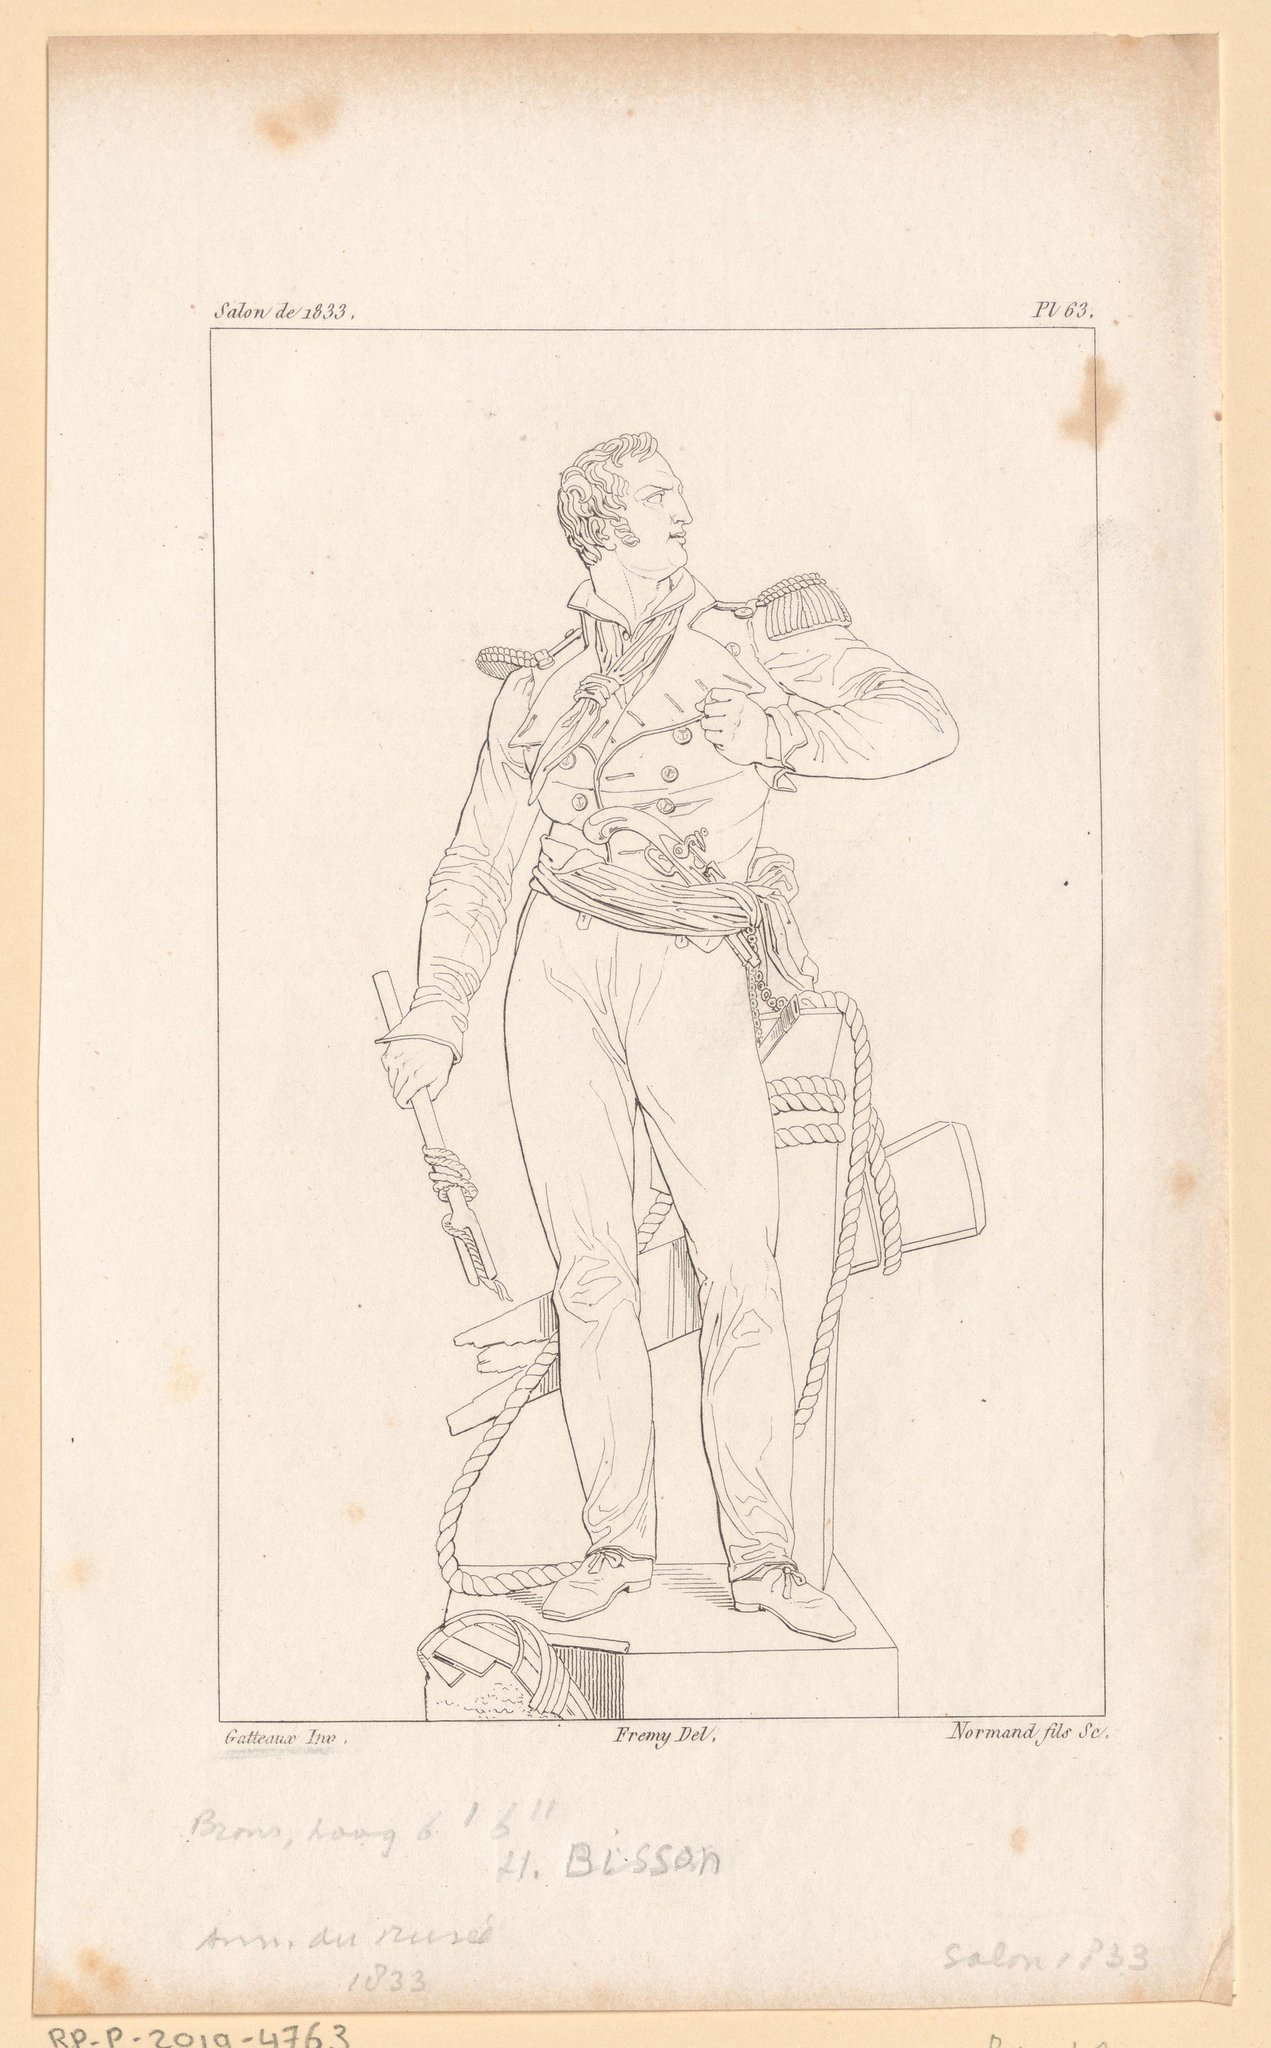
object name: book illustration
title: Portret van Hippolyte Magloire Bisson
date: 1833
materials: paper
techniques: etching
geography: paris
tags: historical persons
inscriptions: date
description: Prent uit: Laviron, Gabriel en Bruno Galbacio. Le salon de 1833. Parijs: Abel Ledoux, 1833.